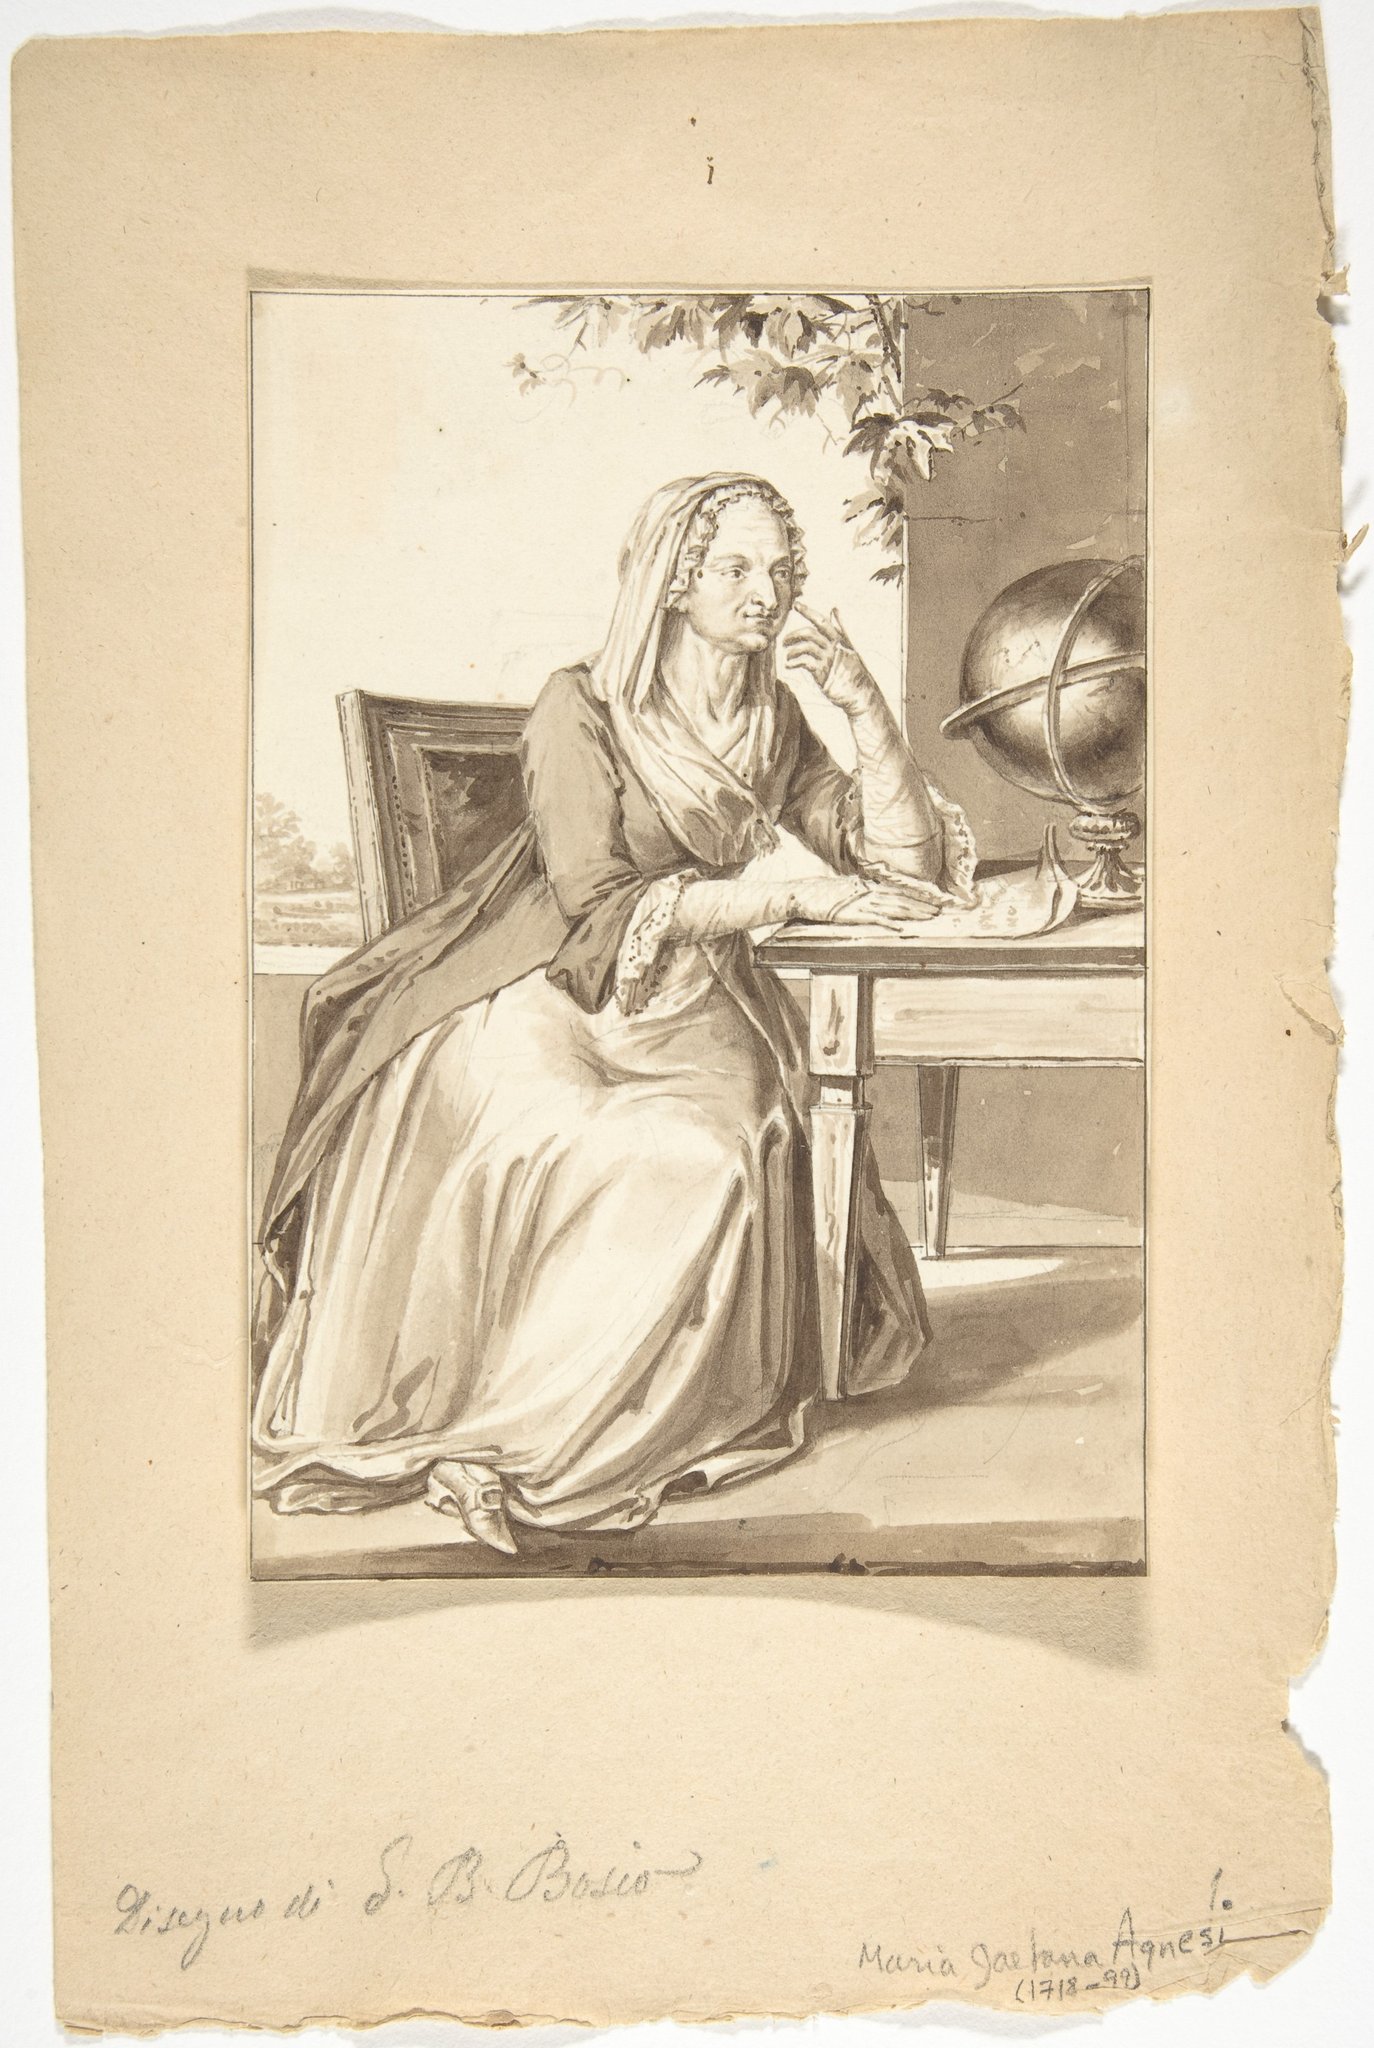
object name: drawing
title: Portrait of Maria Gaet - Agnesi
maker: jean-baptiste-françois bosio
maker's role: artist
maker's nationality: french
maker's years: 1764-1827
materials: graphite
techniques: brush, wash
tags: portraits,women,globes